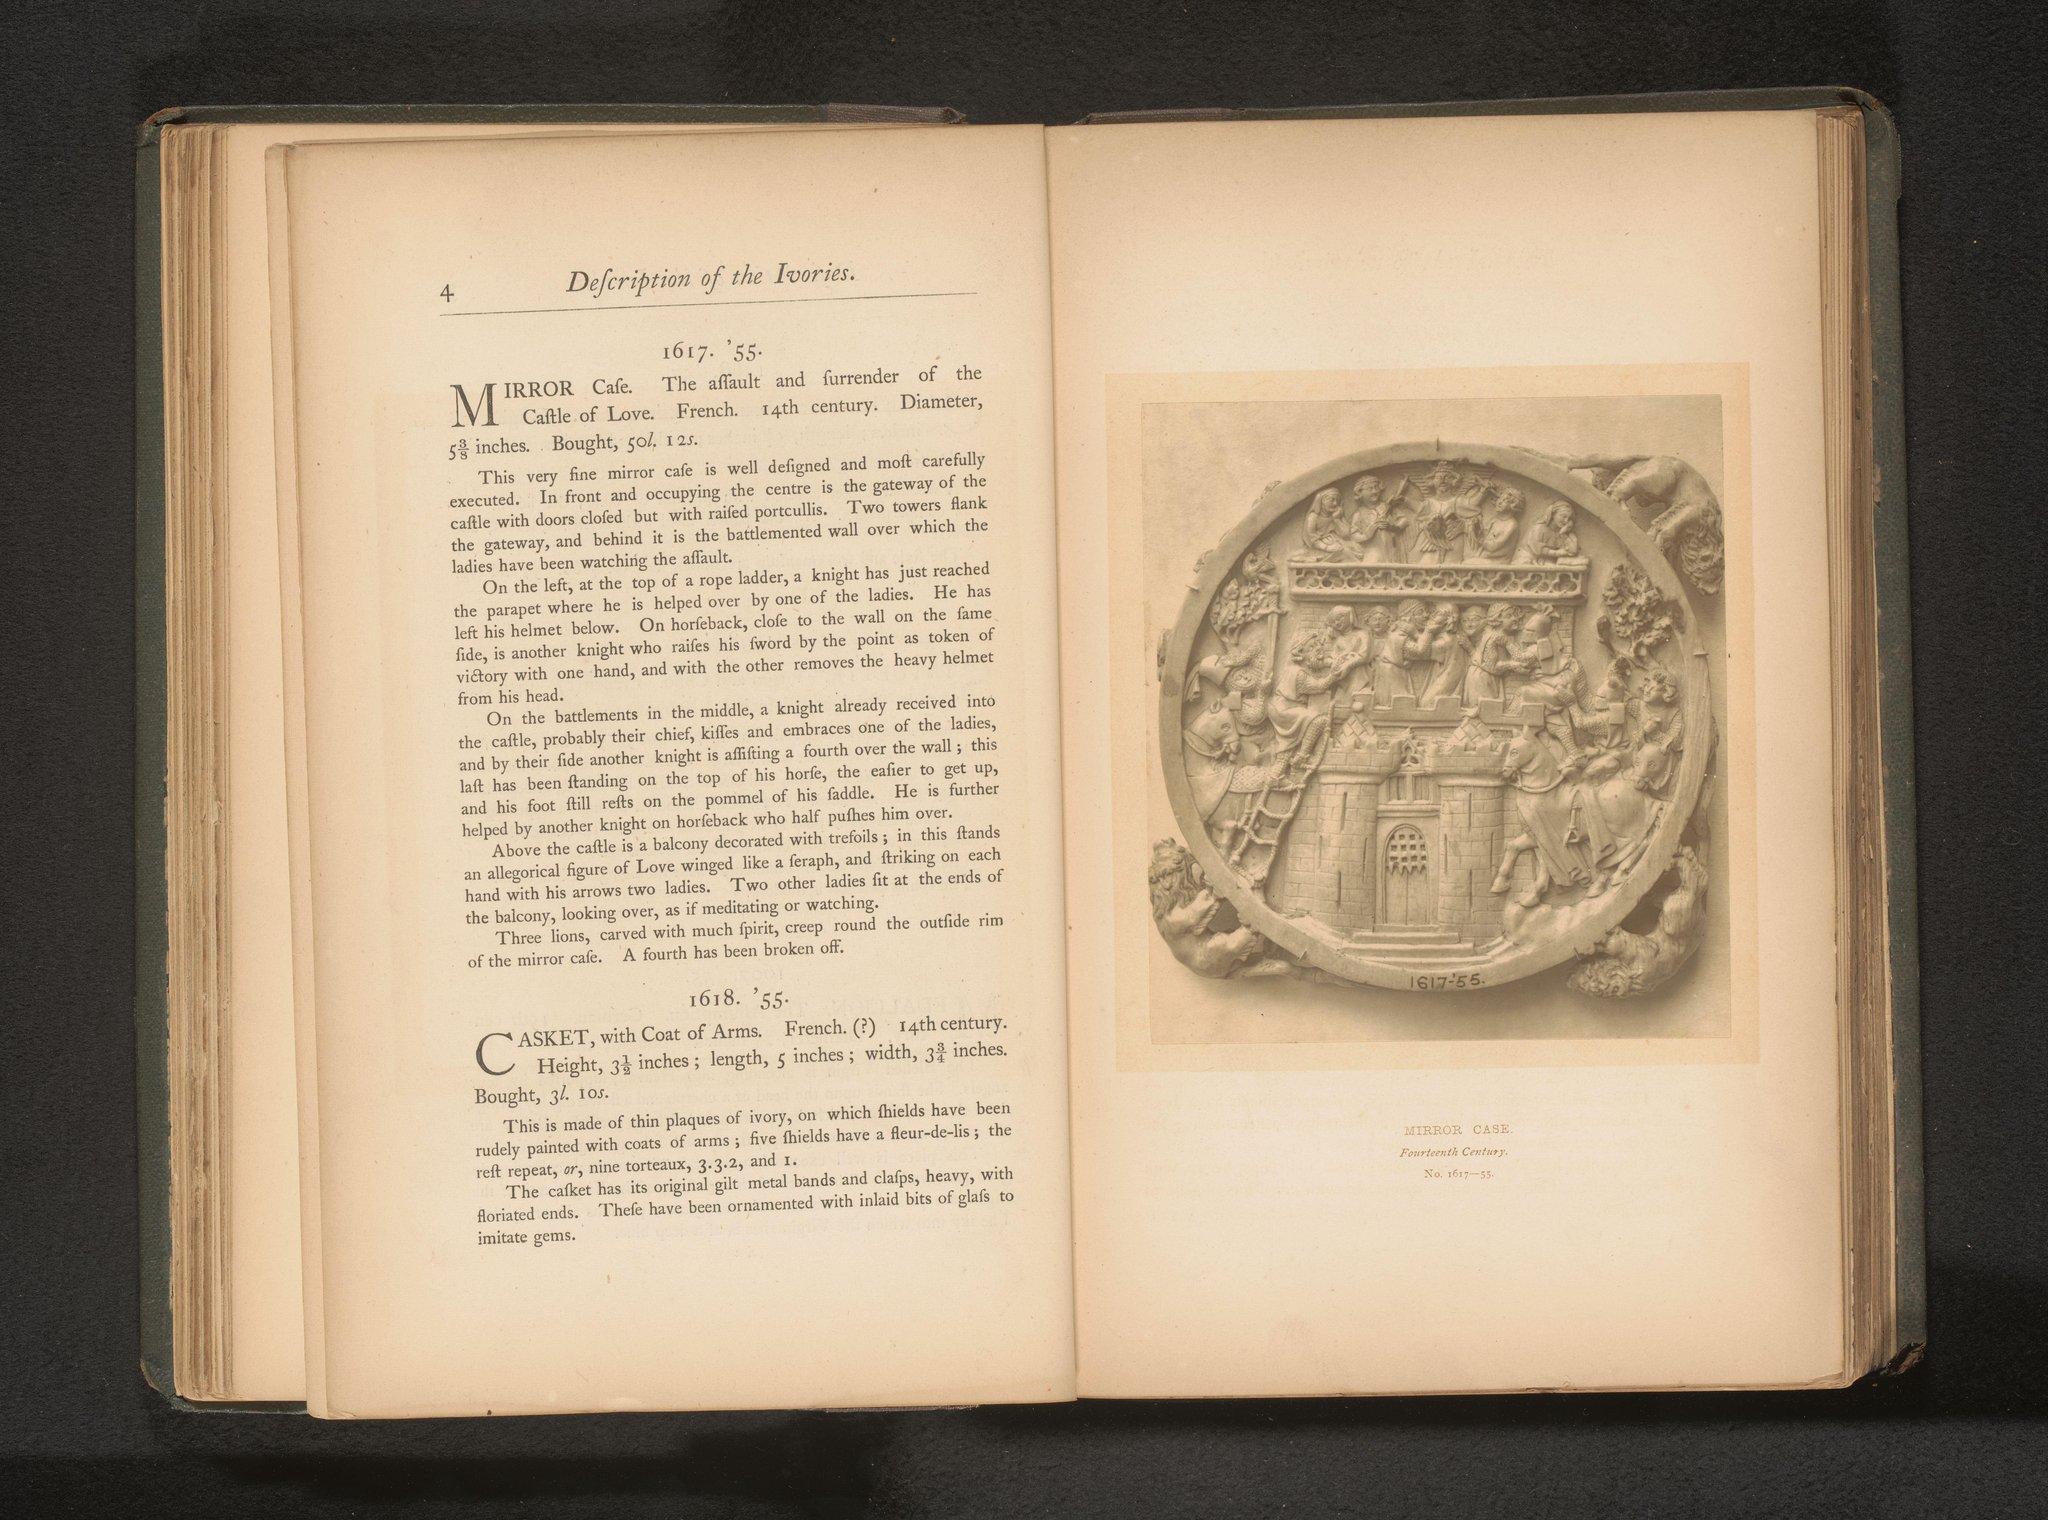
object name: page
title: Mirror case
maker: Anonymous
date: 1867-1872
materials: paper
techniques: woodburytype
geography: london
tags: castle of love, sculpture (+ relief ~ sculpture)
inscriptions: inscription: ‘Fourteenth Century.’, number: ‘No. 1617-55.’